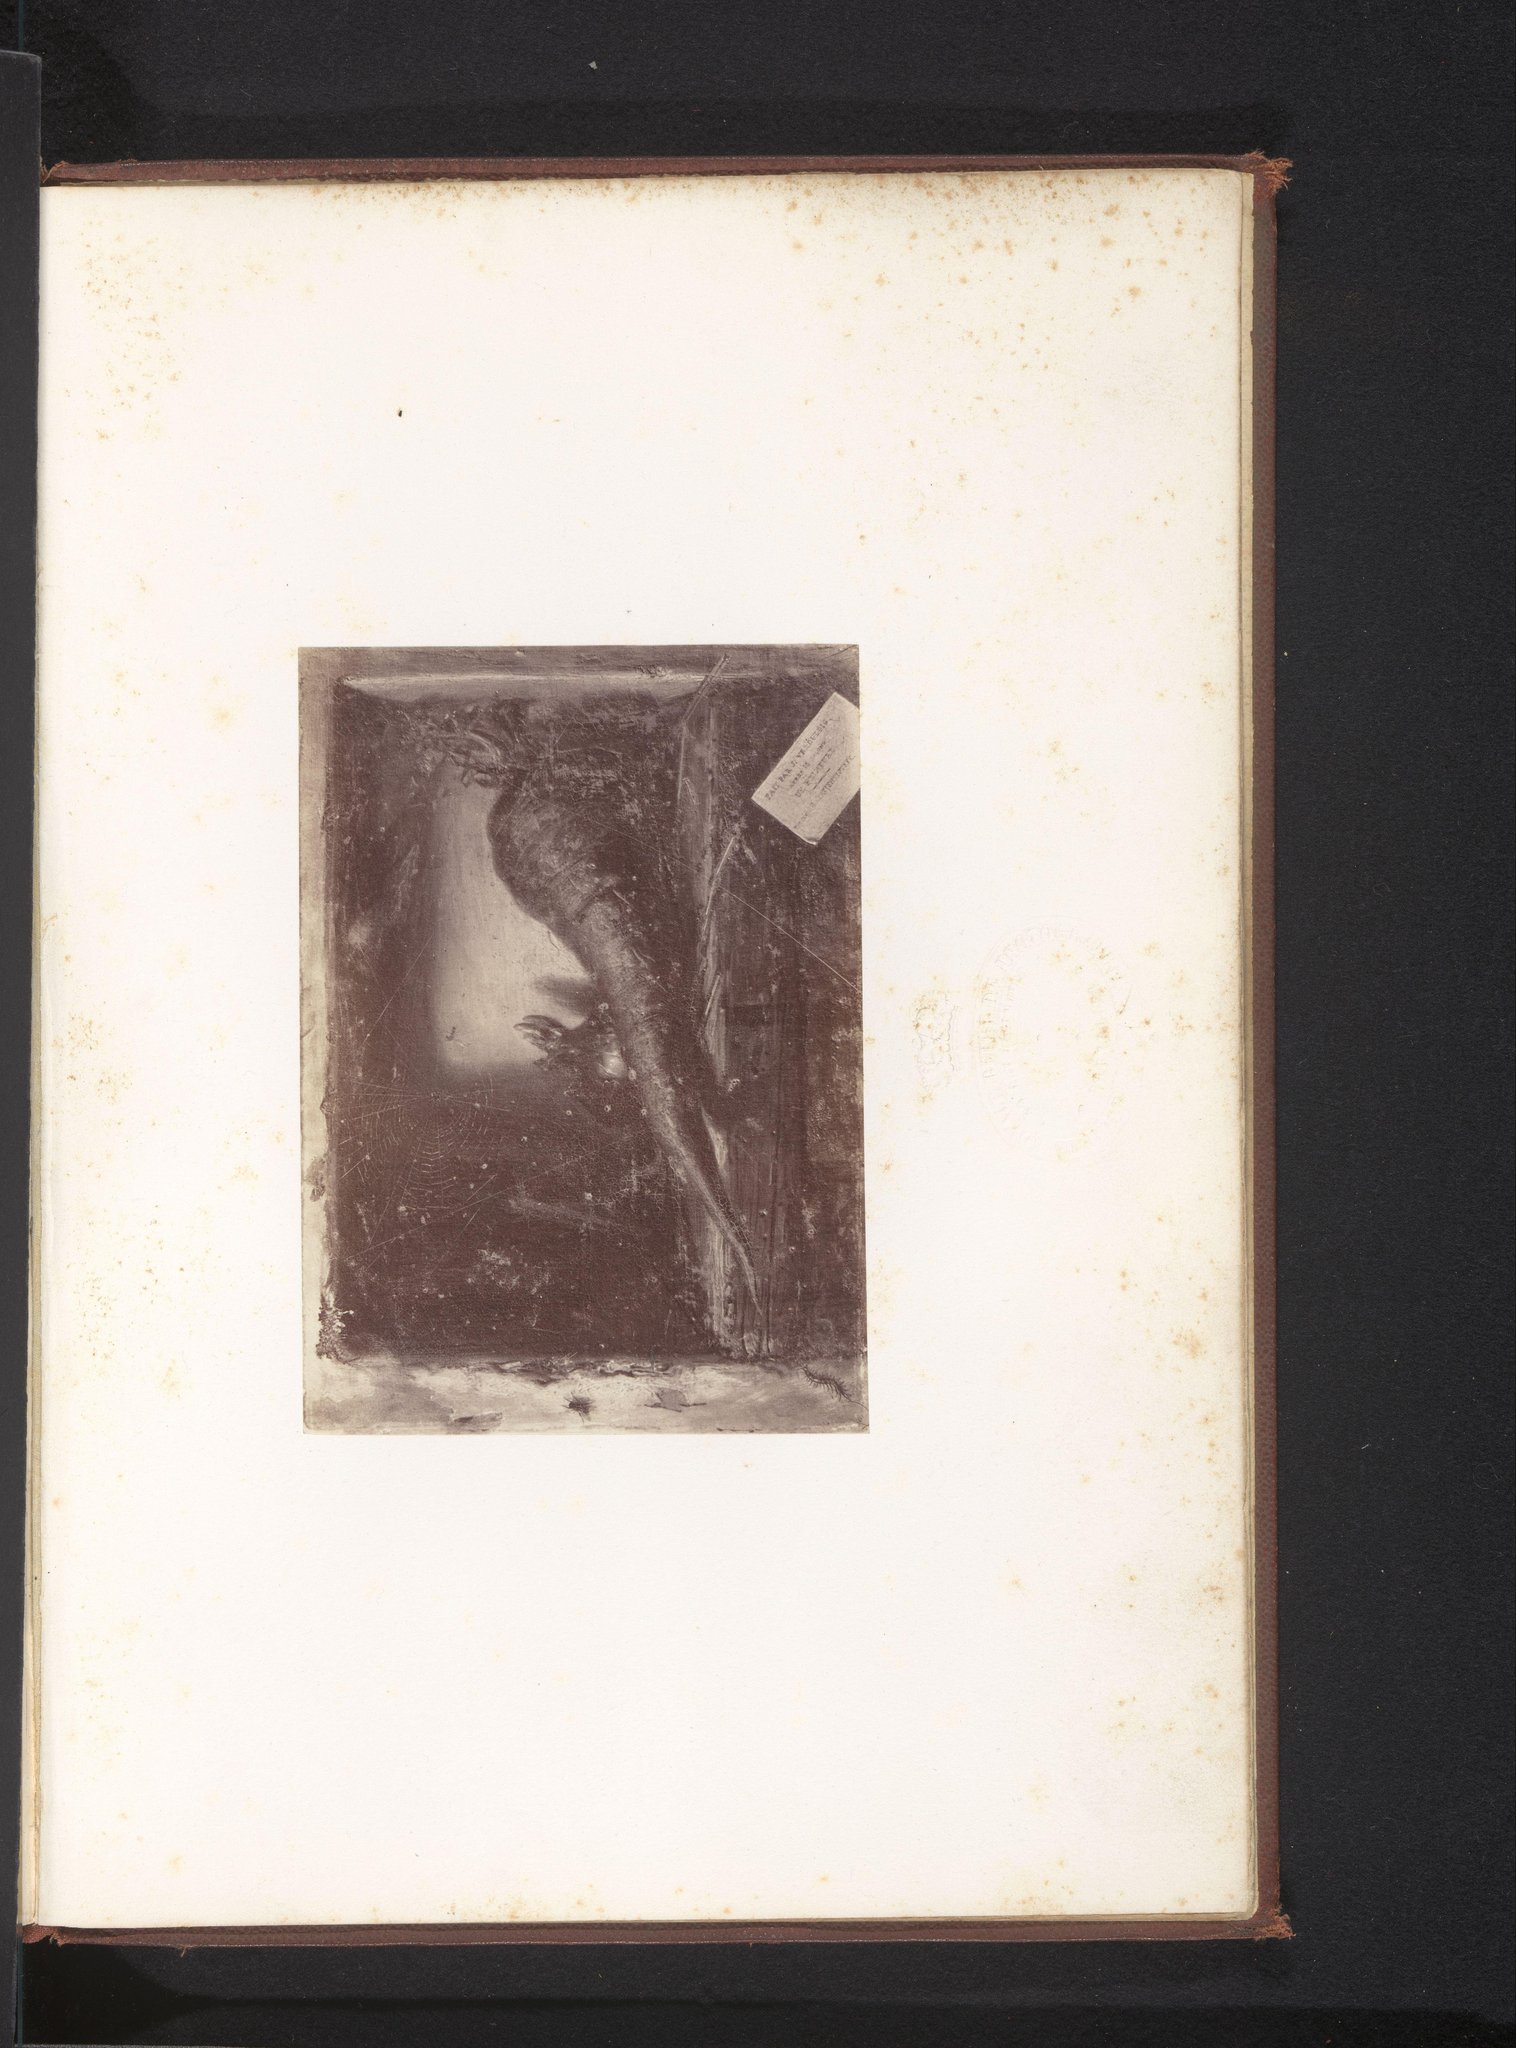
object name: photograph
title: Fotoreproductie van Een wortel met patientiotype door Antoine Wiertz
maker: edmond fierlants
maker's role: fotograaf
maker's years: 1819-1869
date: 1863-1868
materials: photographic support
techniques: albumen print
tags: vegetables (with name)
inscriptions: check stamp: ‘SOCIÉTÉ ROYALE BELGE DE PHOTOGRAPHIE/ 69, RUE KEYENVELD/ BRUXELLES’